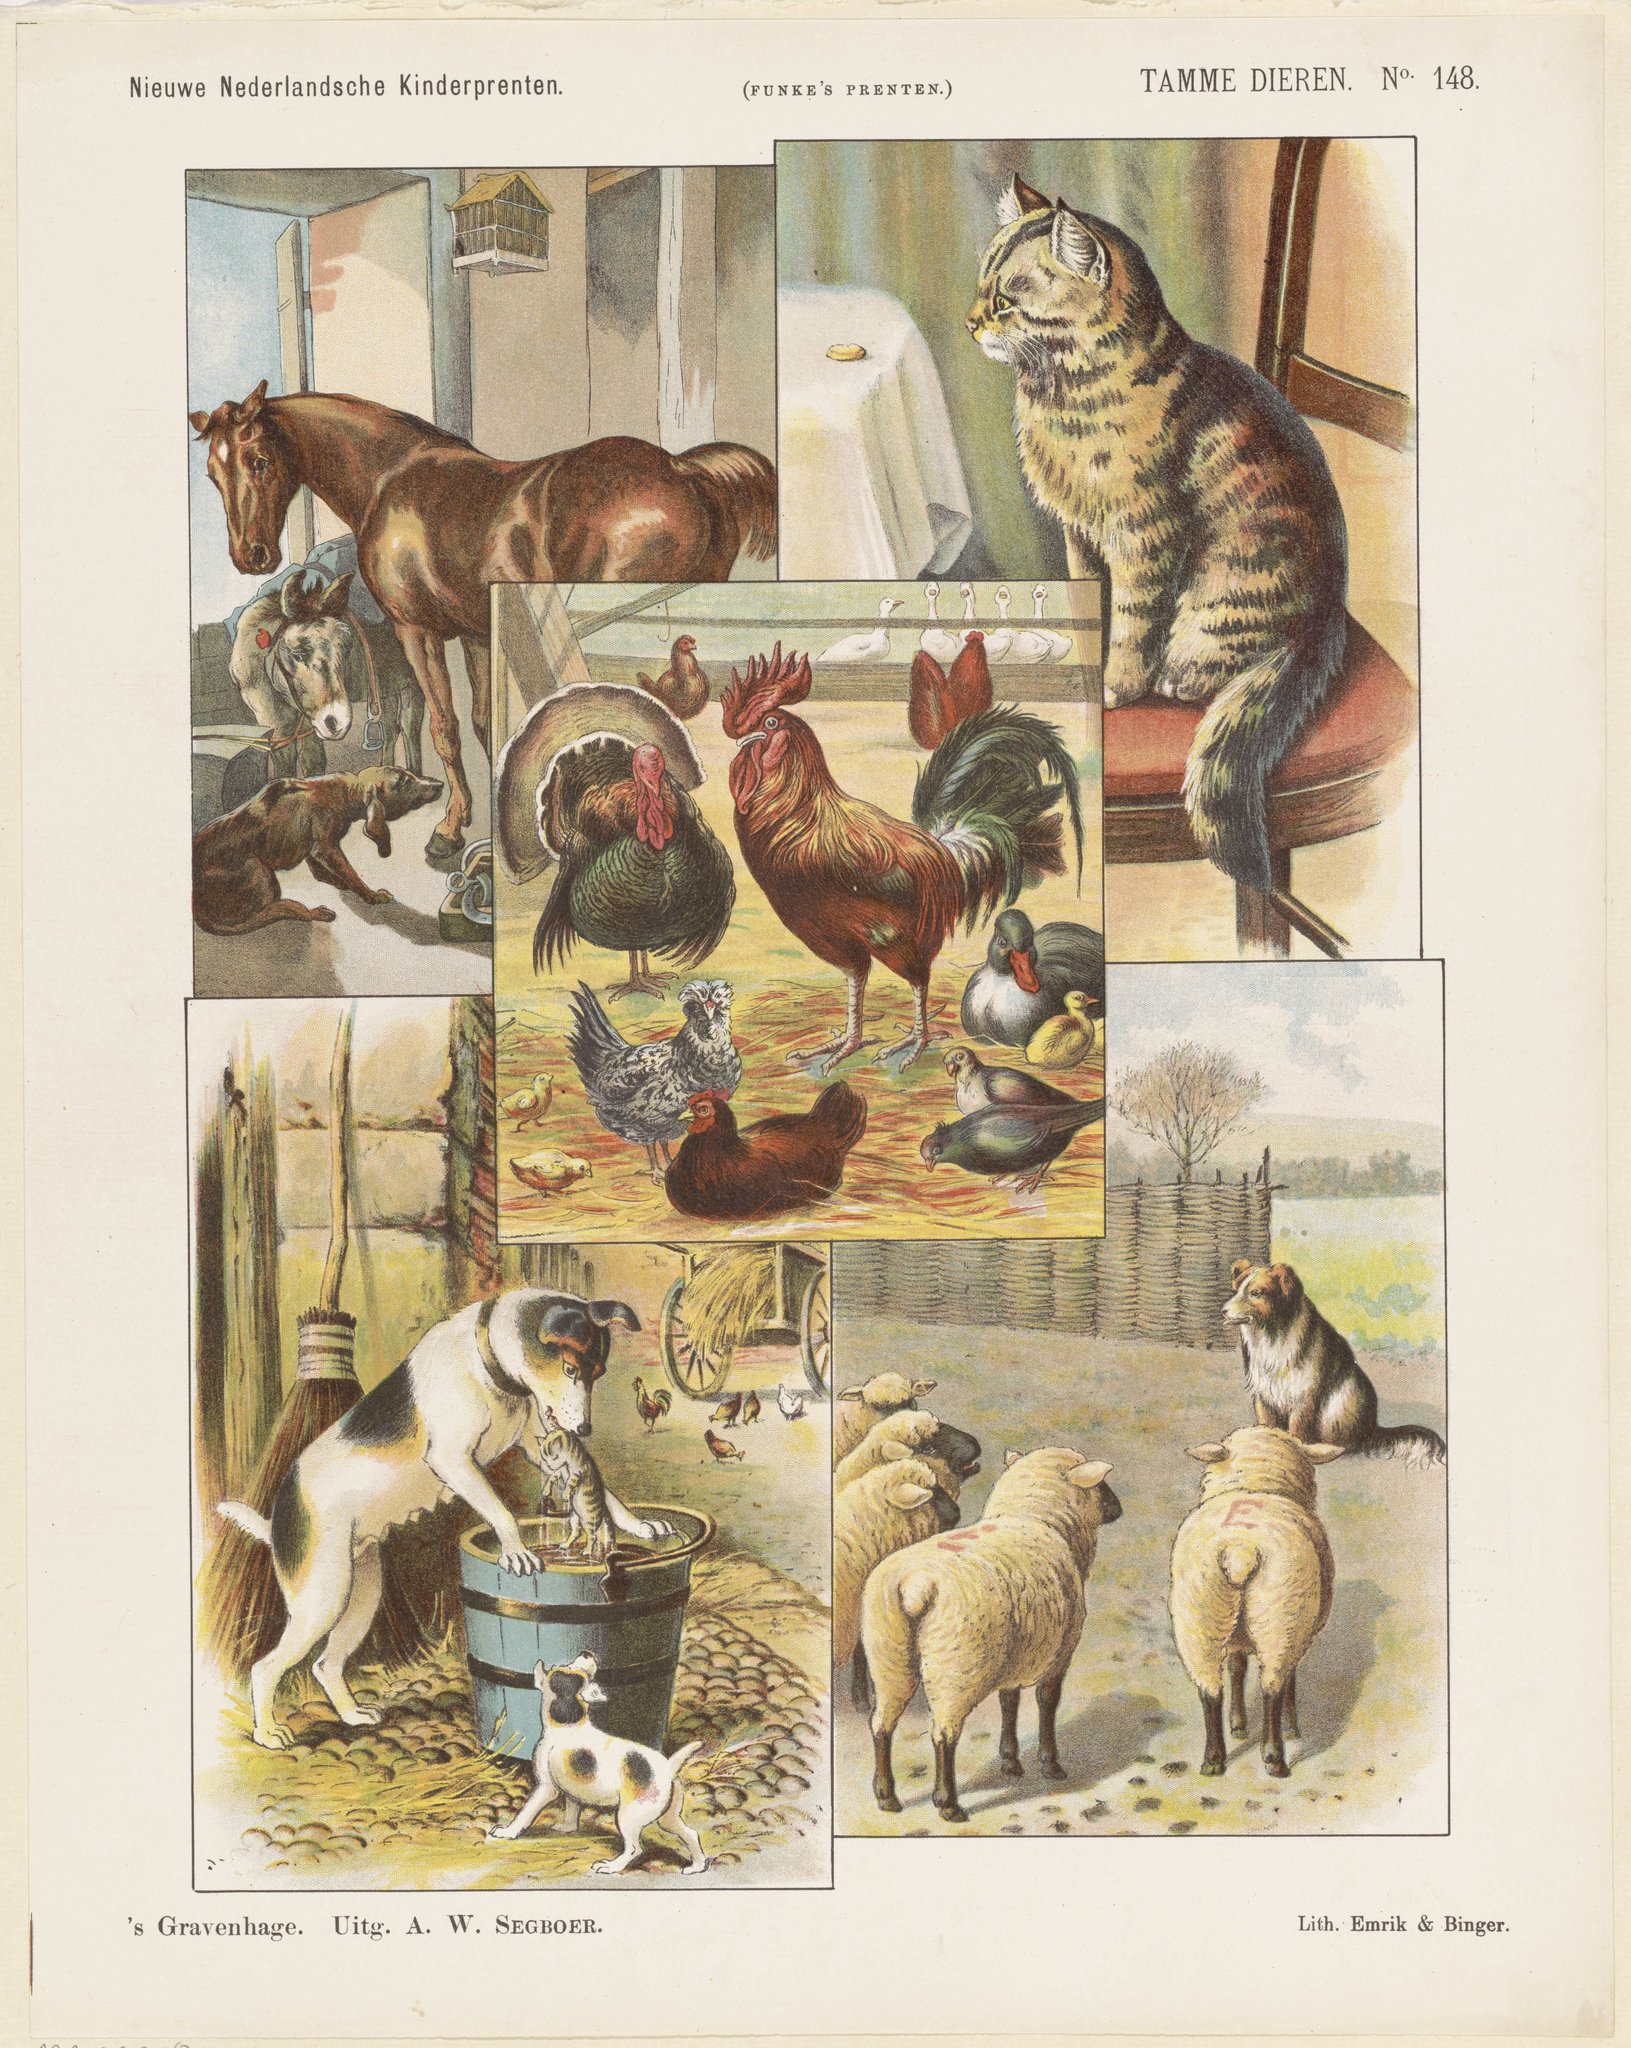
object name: print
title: Tamme dieren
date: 1903-1919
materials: paper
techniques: lithograph, letterpress printing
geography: haarlem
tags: animals, fowl (cock, hen, chicken, etc.), horse, dog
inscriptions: collector's mark: Lugt 2760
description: Blad met 5 voorstellingen van boerderijdieren, zoals een paard, een ezel, schapen, kippen en een kat. Genummerd rechtsboven: No. 148.